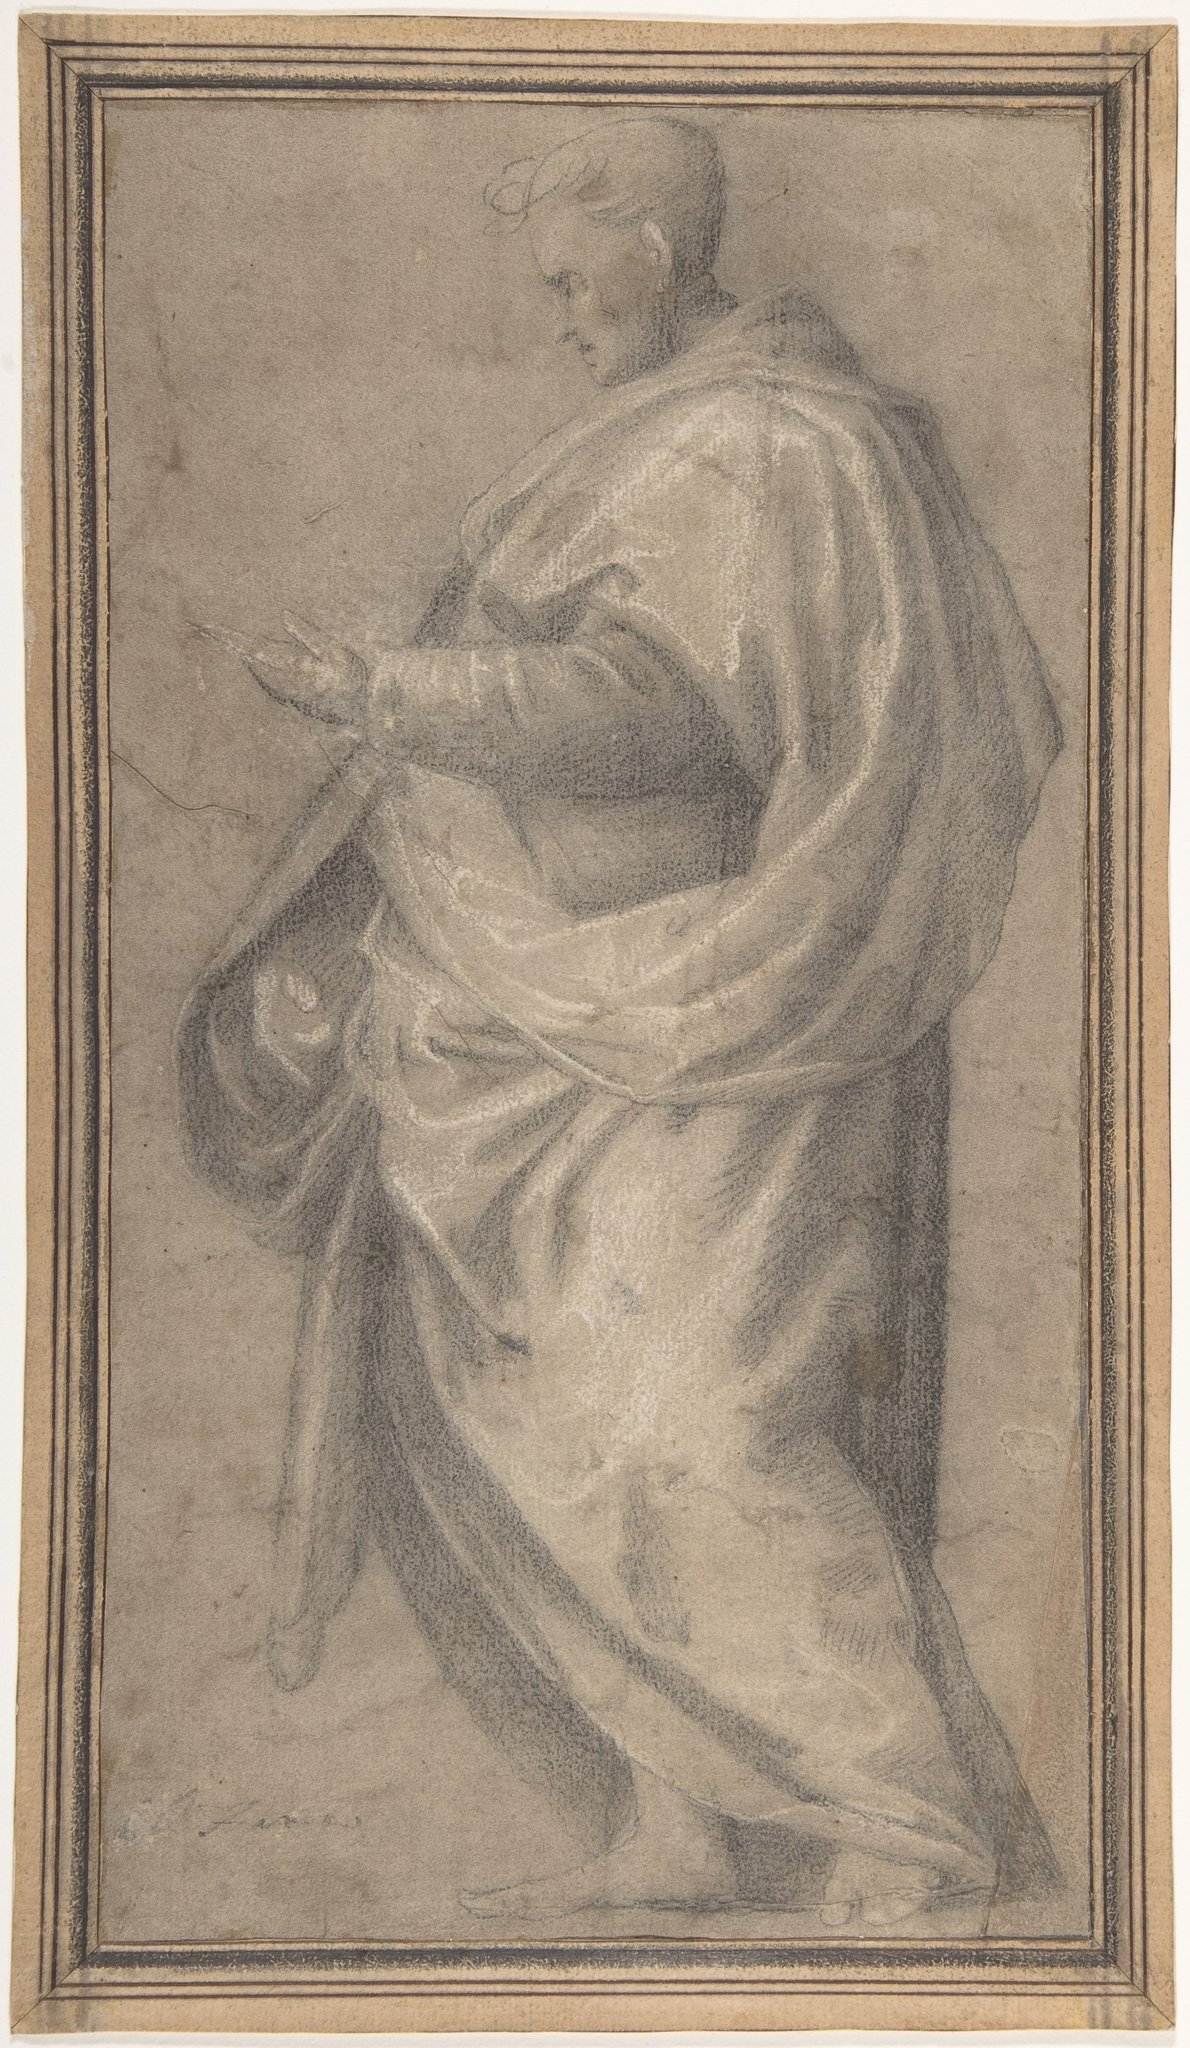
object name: drawing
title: Drapery Study for a Standing Male Figure in Profile Facing Left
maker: fra bartolomeo (bartolomeo di paolo del fattorino)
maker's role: artist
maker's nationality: italian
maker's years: 1473-1517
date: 1512-1517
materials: chalk, paper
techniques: highlighting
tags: men,profiles